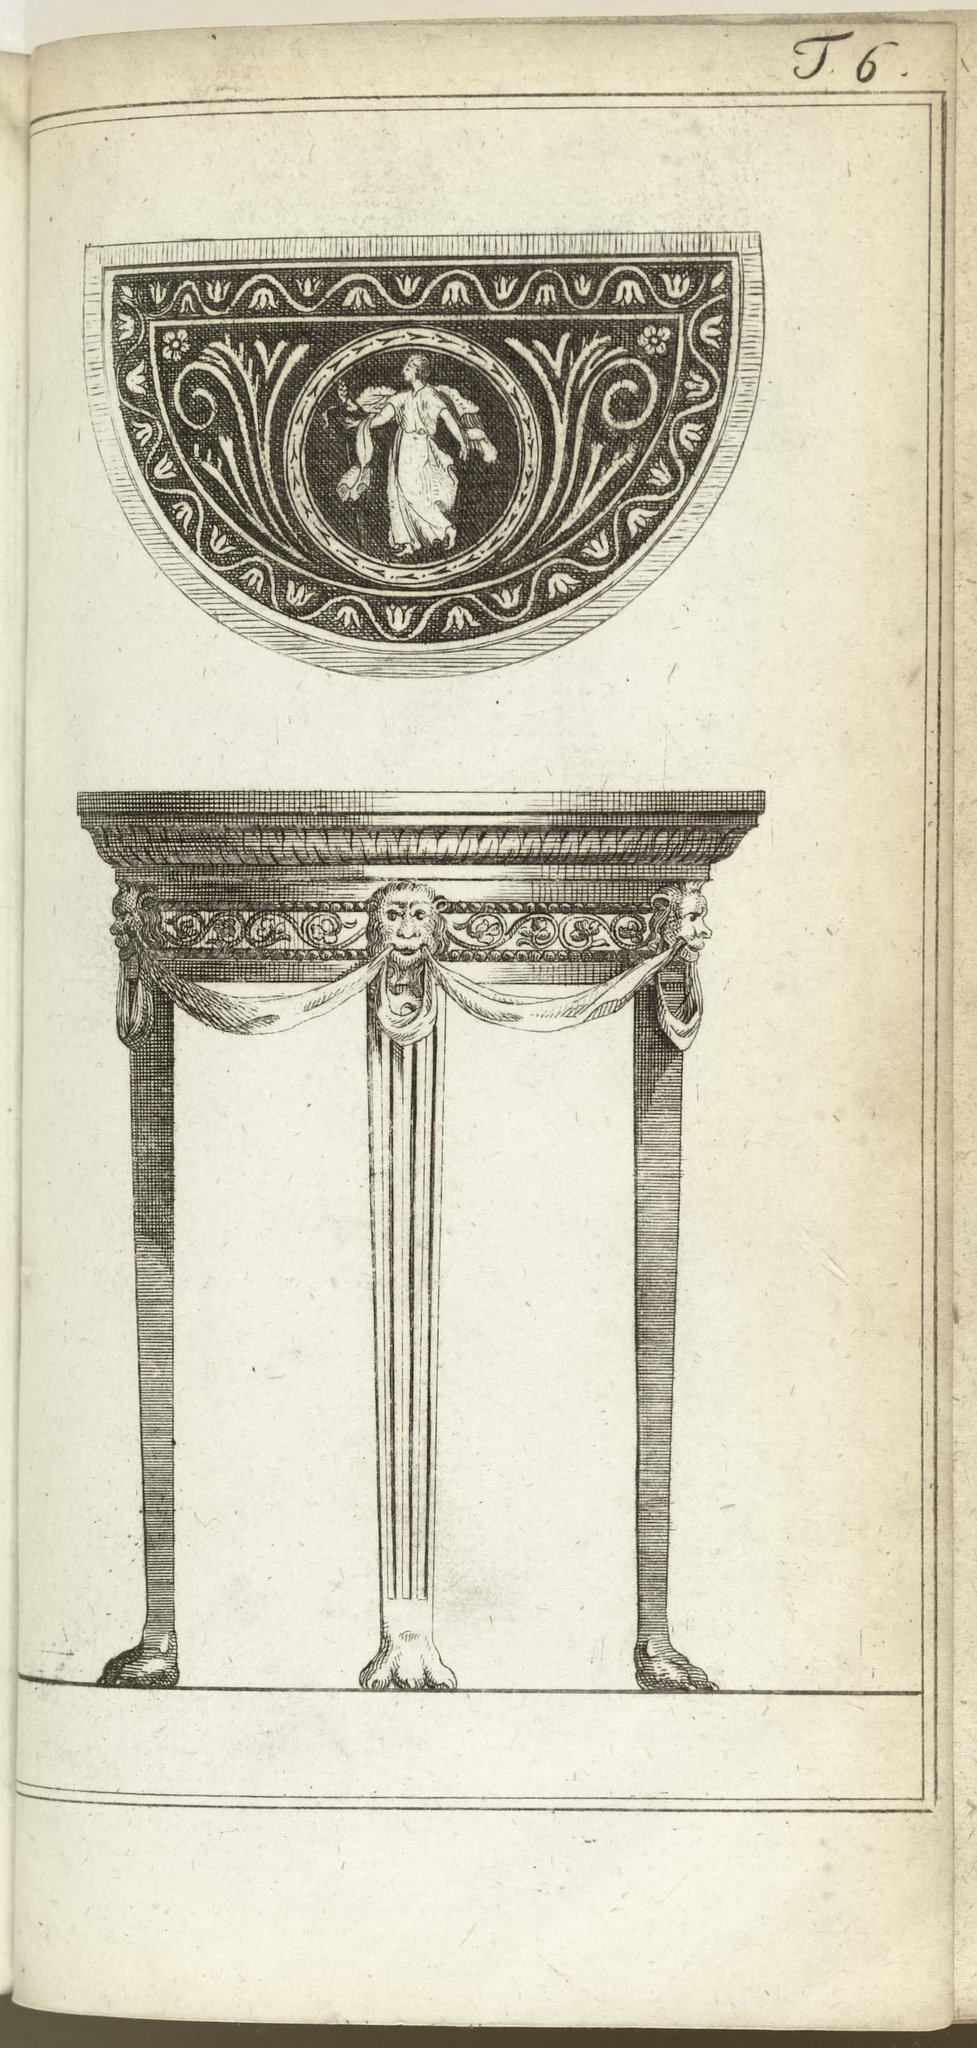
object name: magazine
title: Journal des Luxus und der Moden 1790, Band V, T.6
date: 1790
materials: paper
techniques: etching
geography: weimar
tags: fashion plates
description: Prent uit het modetijdschrift Journal des Luxus und der Moden, uitgegeven door Friedrich Justin Bertuch en Georg Melchior Kraus, Weimar, 1786-1826.